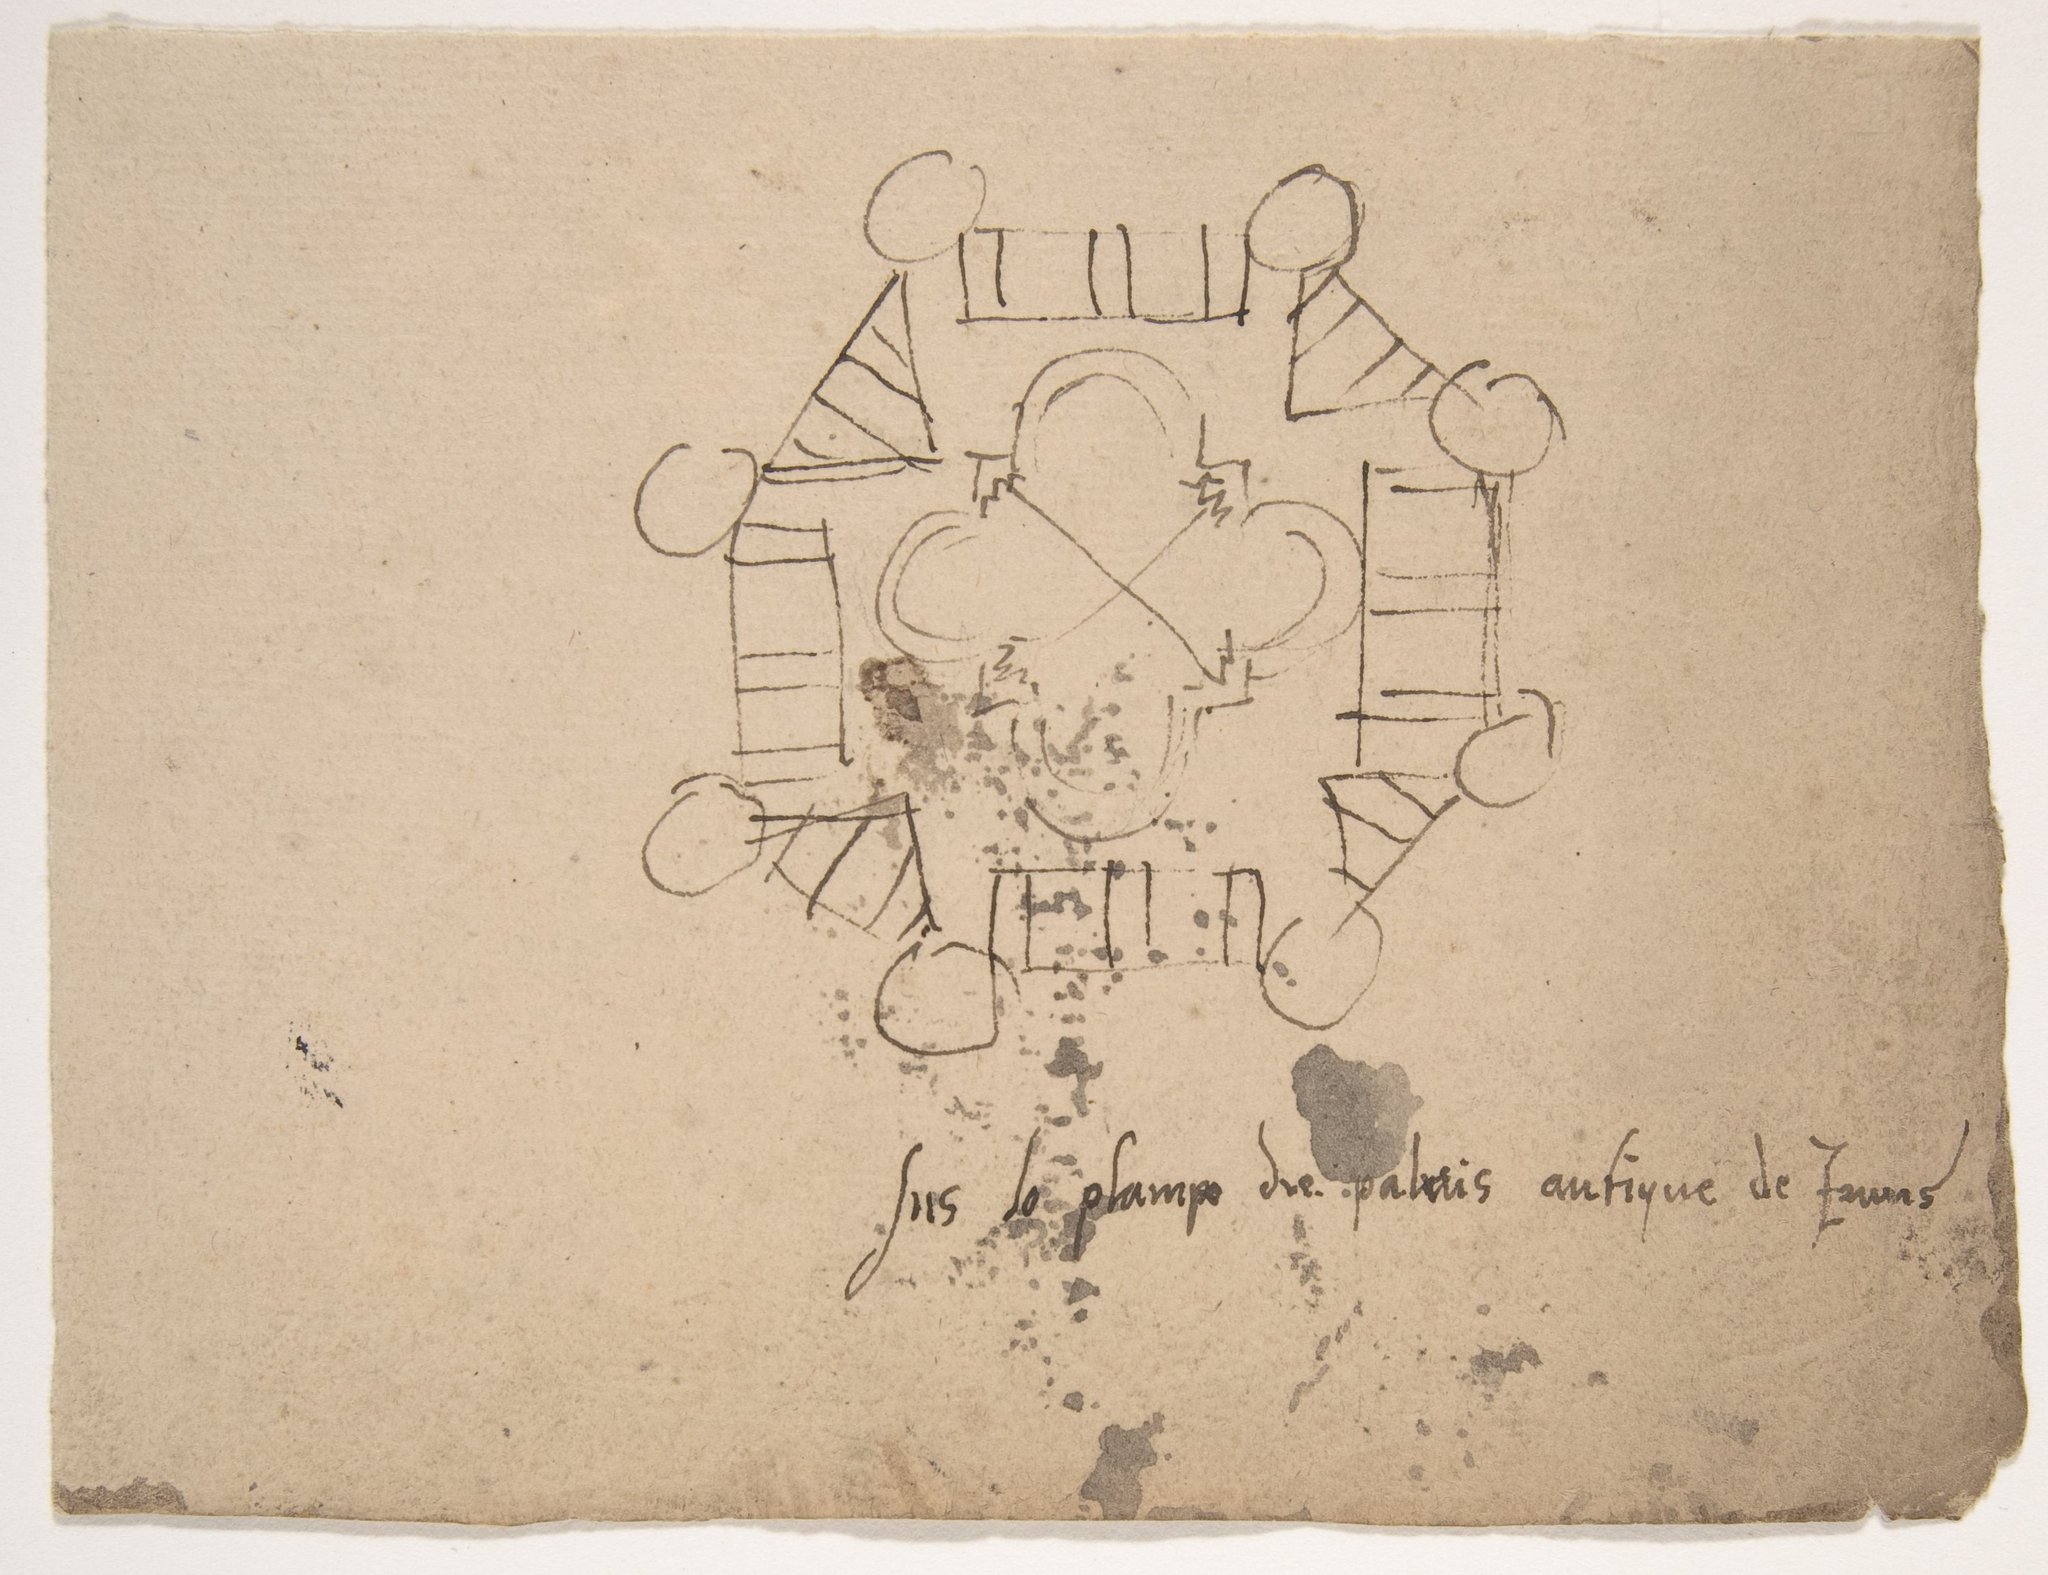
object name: collection ornament architecture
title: Unidentified, plan (recto) blank (verso)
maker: anonymous, french, 16th century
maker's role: draftsman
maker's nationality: french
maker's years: 1500-1600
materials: chalk, ink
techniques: incising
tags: architecture